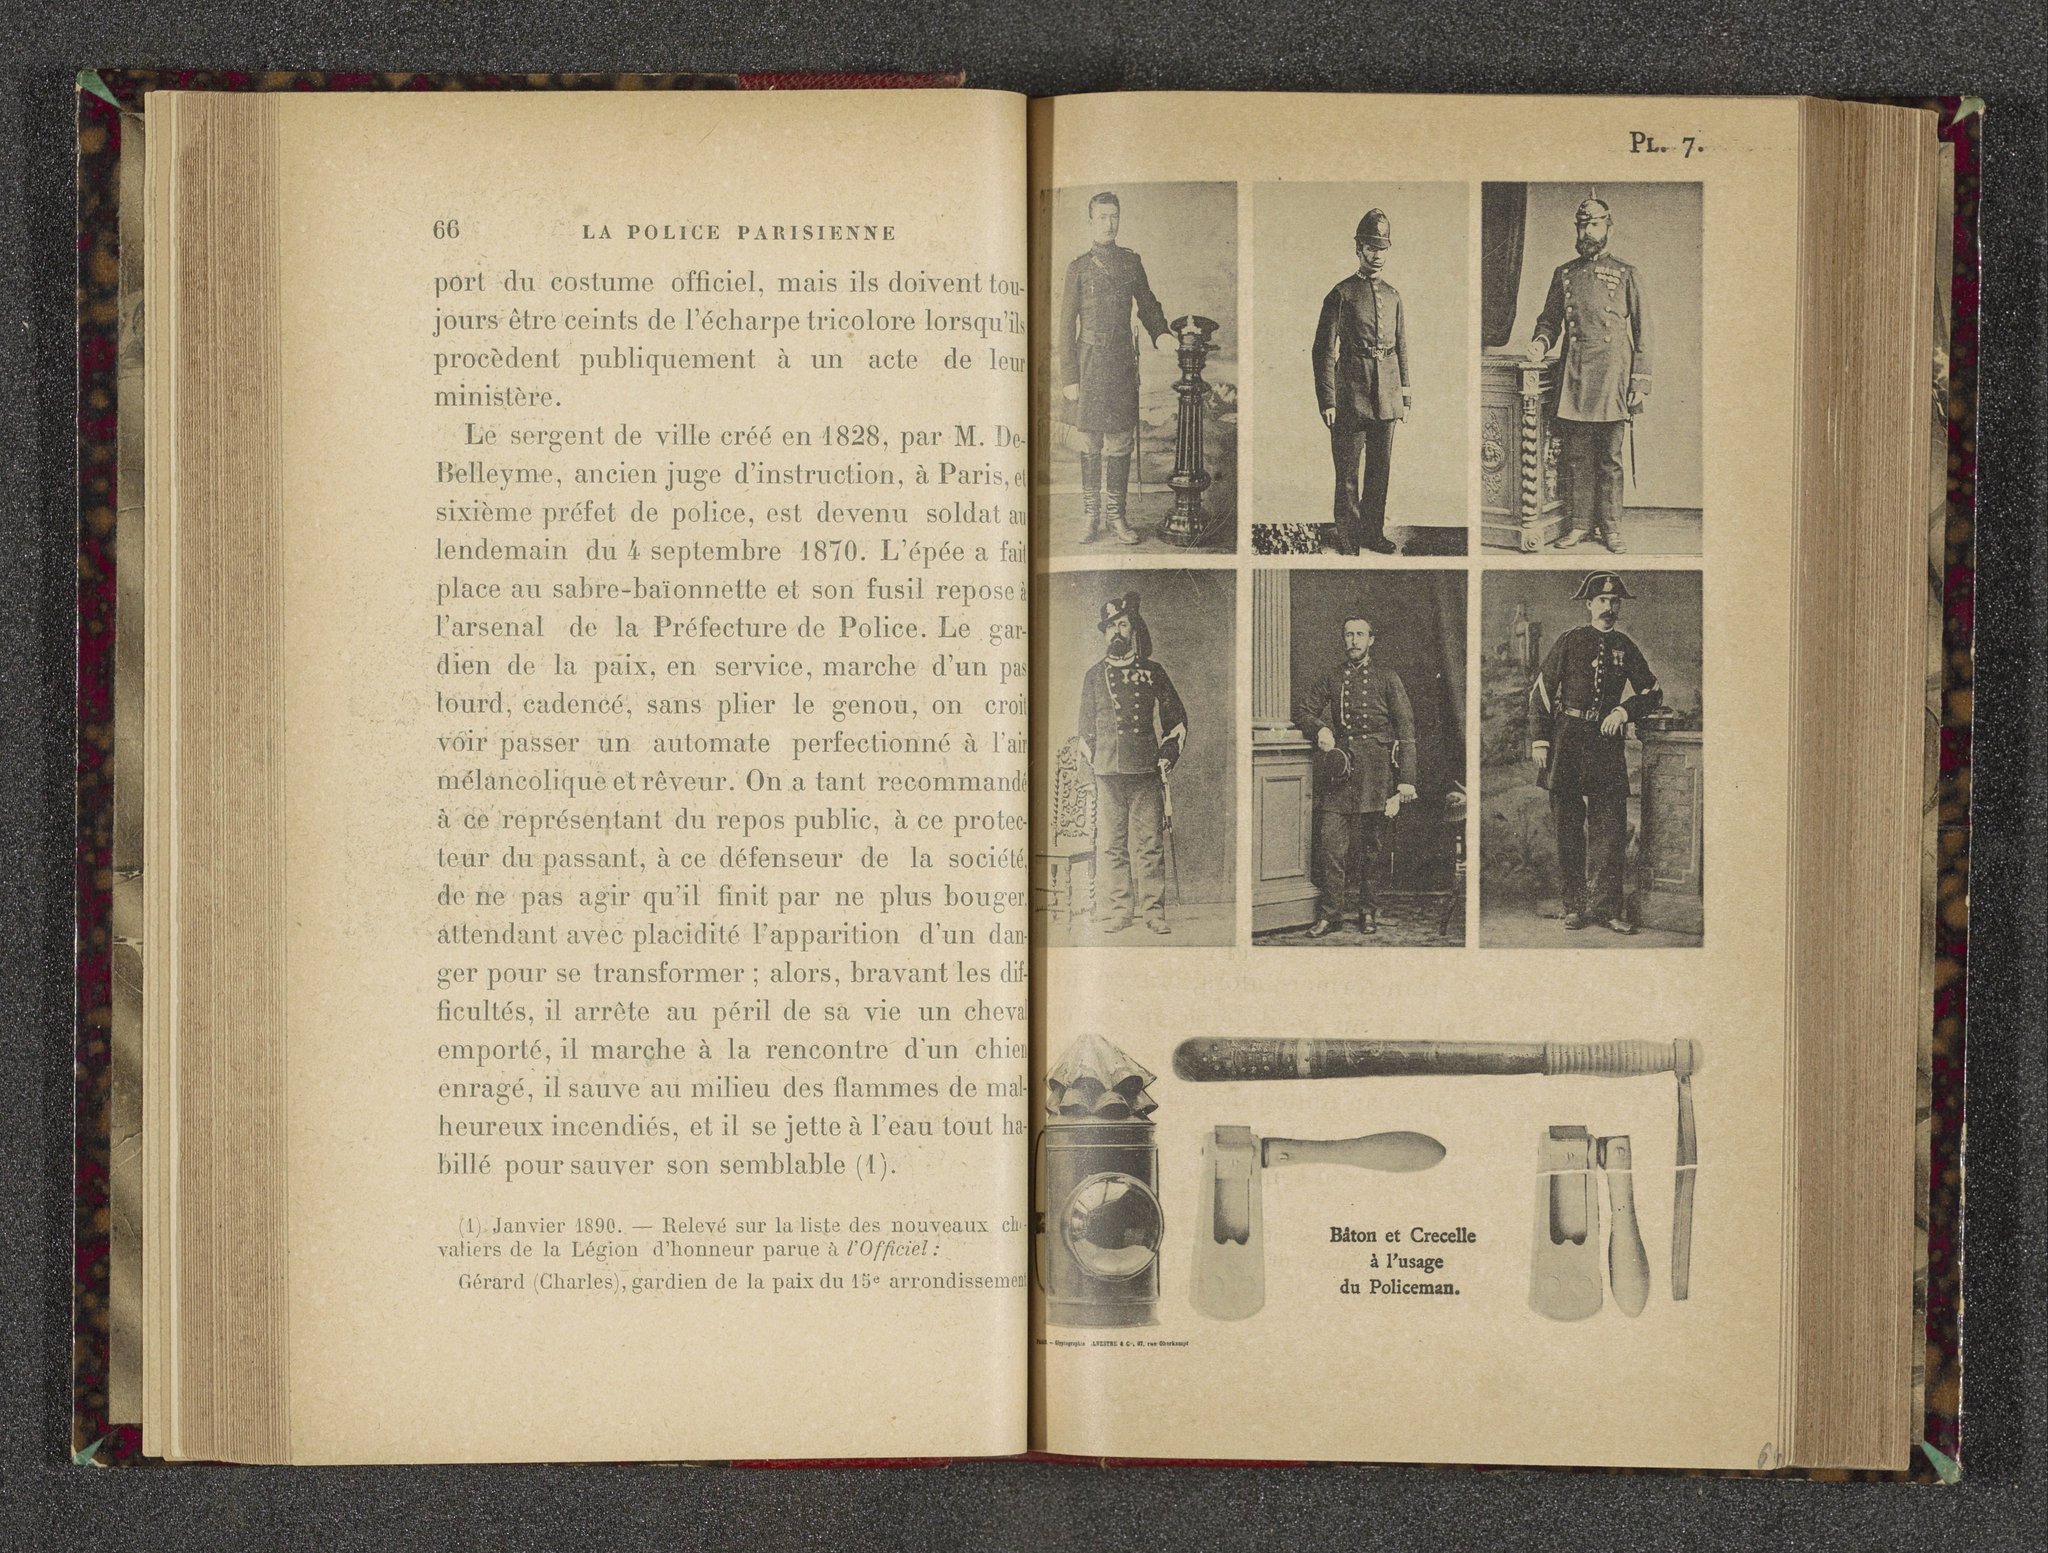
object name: photomechanical print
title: Zes politiemannen met daaronder hun hulpmiddelen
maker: Anonymous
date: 1880-1890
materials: paper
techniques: photograph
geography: paris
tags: rattle ~ acoustic signalling, policeman, constable, (military) uniforms, baton of general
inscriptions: inscription: ‘Bâton et Crecelle à l'usage du Policeman.’, number: ‘Pl. 7.’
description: Als hulpmiddelen van de politiemannen zijn een stok, een ratel en een lantaren afgebeeld.